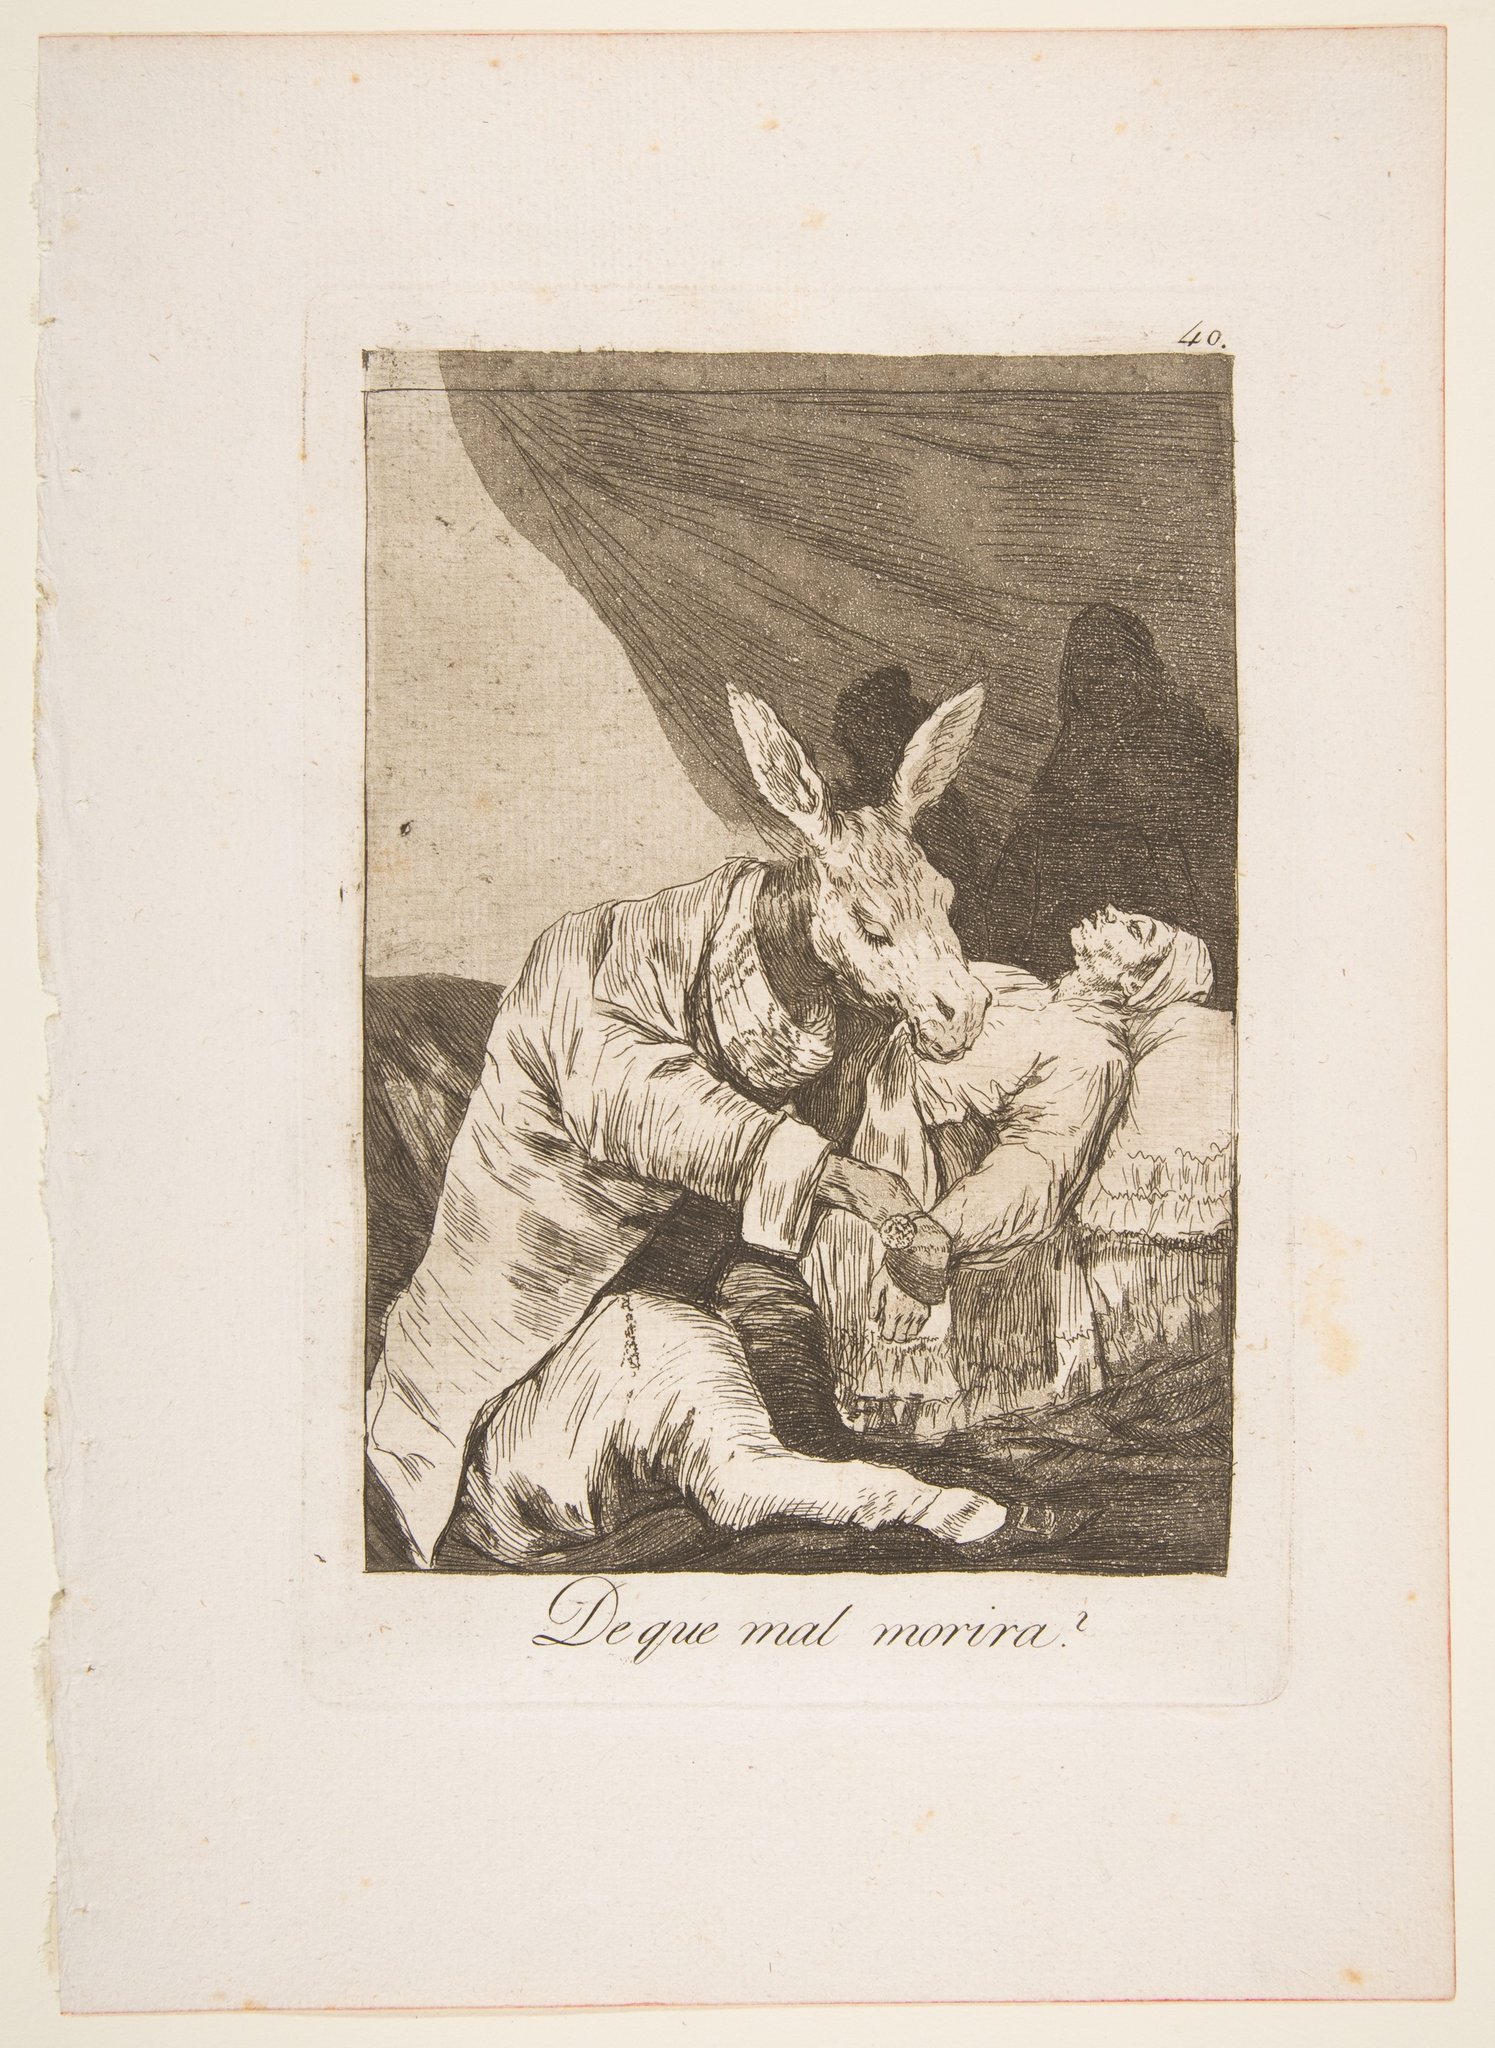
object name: print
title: Plate 40 from "Los Caprichos": Of what ill will he die? (De que mal morira?)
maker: goya (francisco de goya y lucientes)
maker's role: artist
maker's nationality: spanish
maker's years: 1746-1828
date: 1799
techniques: aquatint, engraving, burnishing, drypoint, etching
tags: satire,illness,men,donkeys